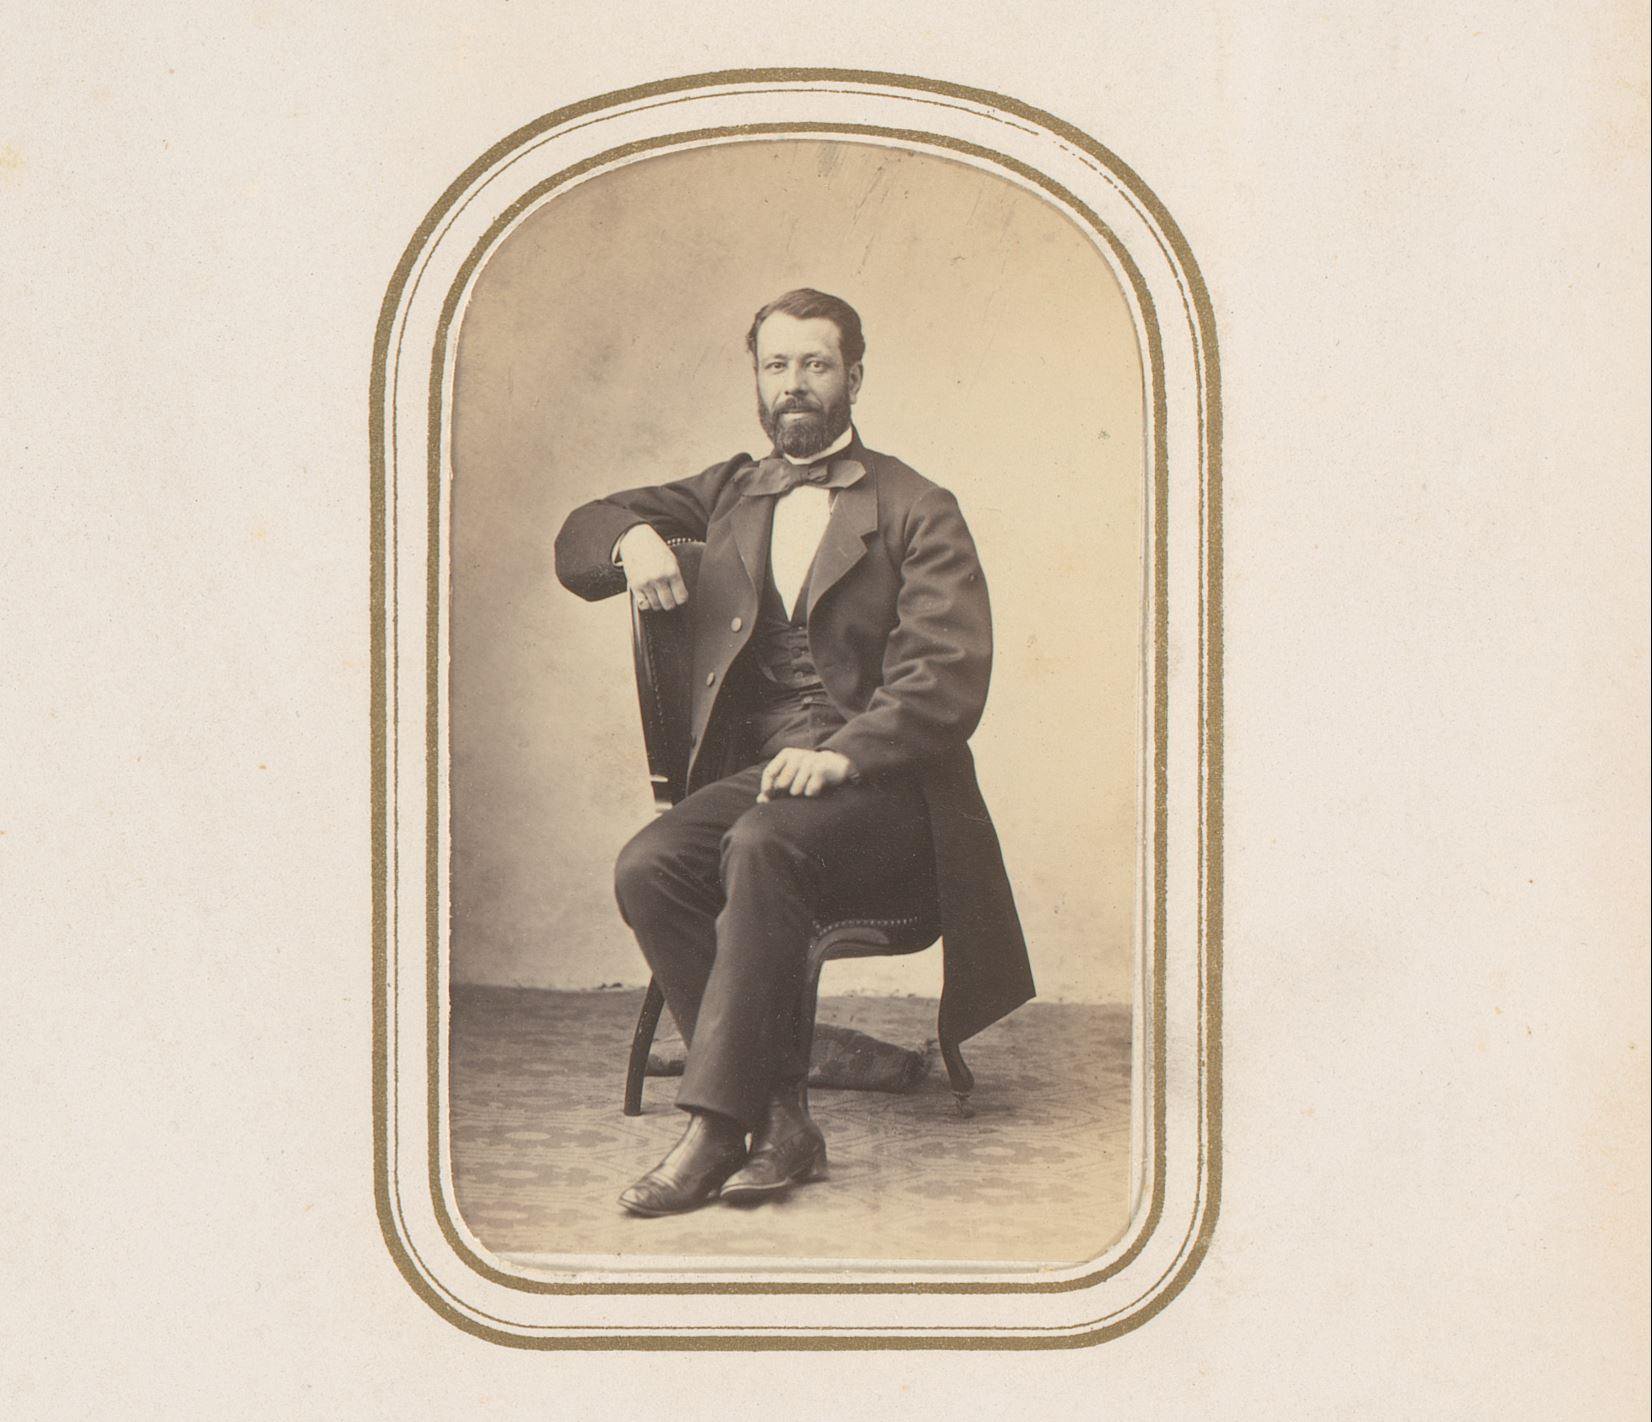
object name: photograph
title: Portret van een zittende man met baard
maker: Anonymous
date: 1850-1890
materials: cardboard, photographic support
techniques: albumen print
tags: sitting figure, adult man, historical persons, beard